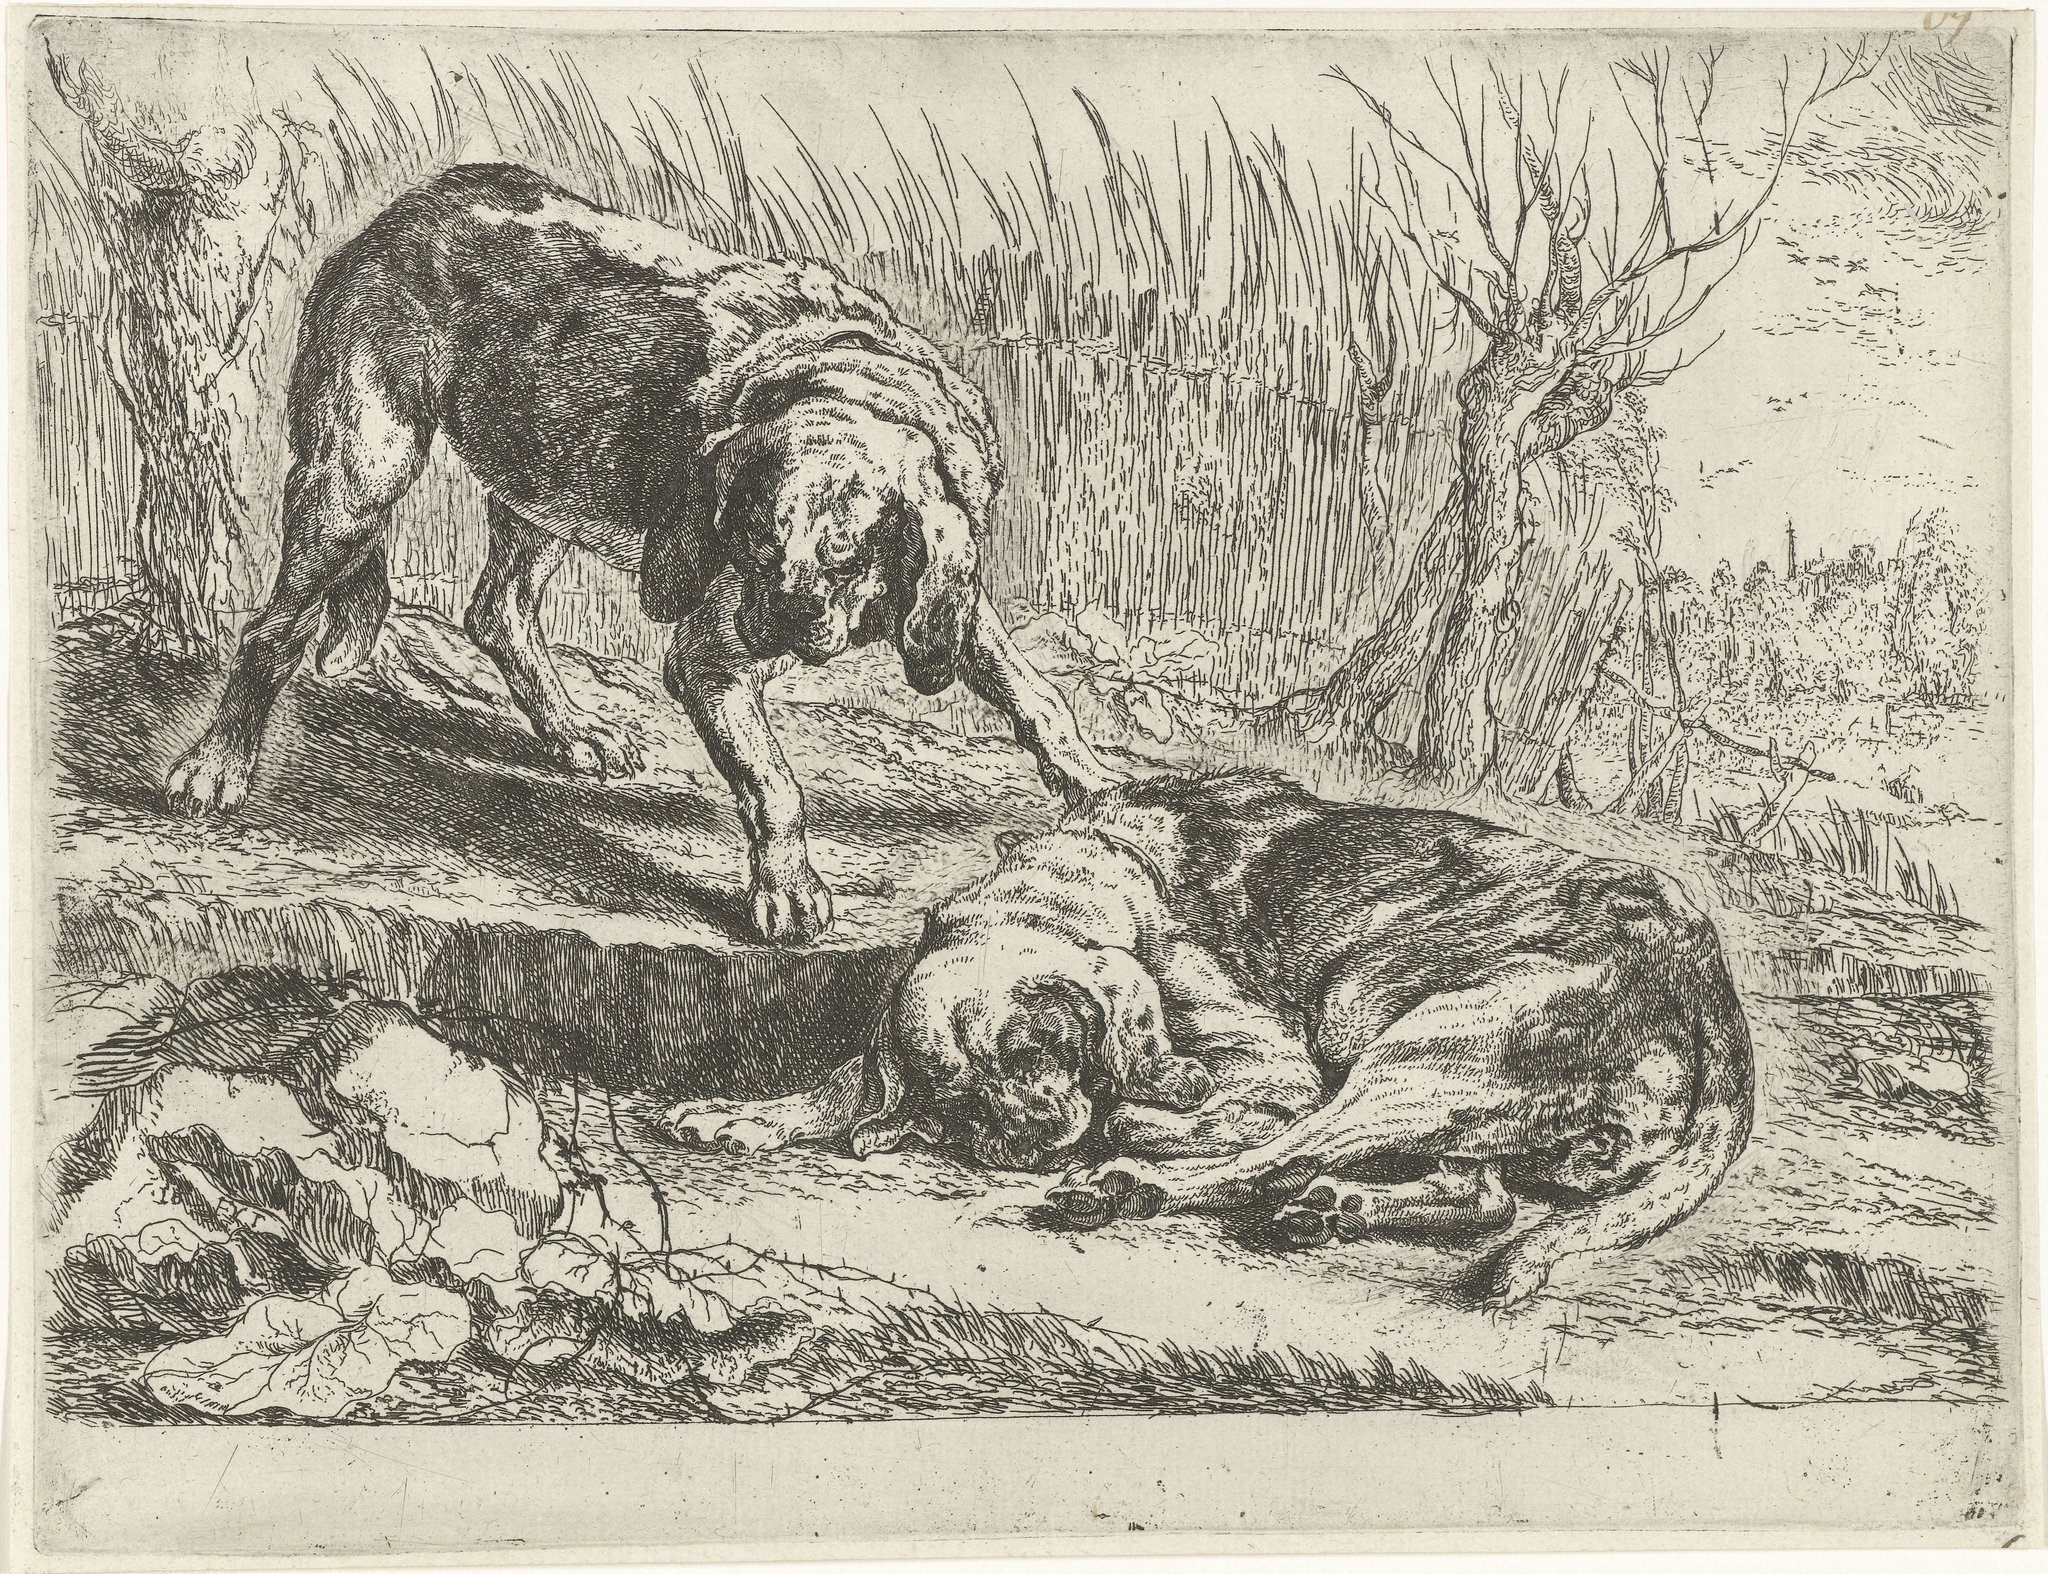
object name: print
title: Honden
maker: joannes fijt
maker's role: draughtsman, print maker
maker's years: 1611-1661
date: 1642-1667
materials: paper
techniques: etching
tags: dog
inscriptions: collector's mark: Lugt 2228